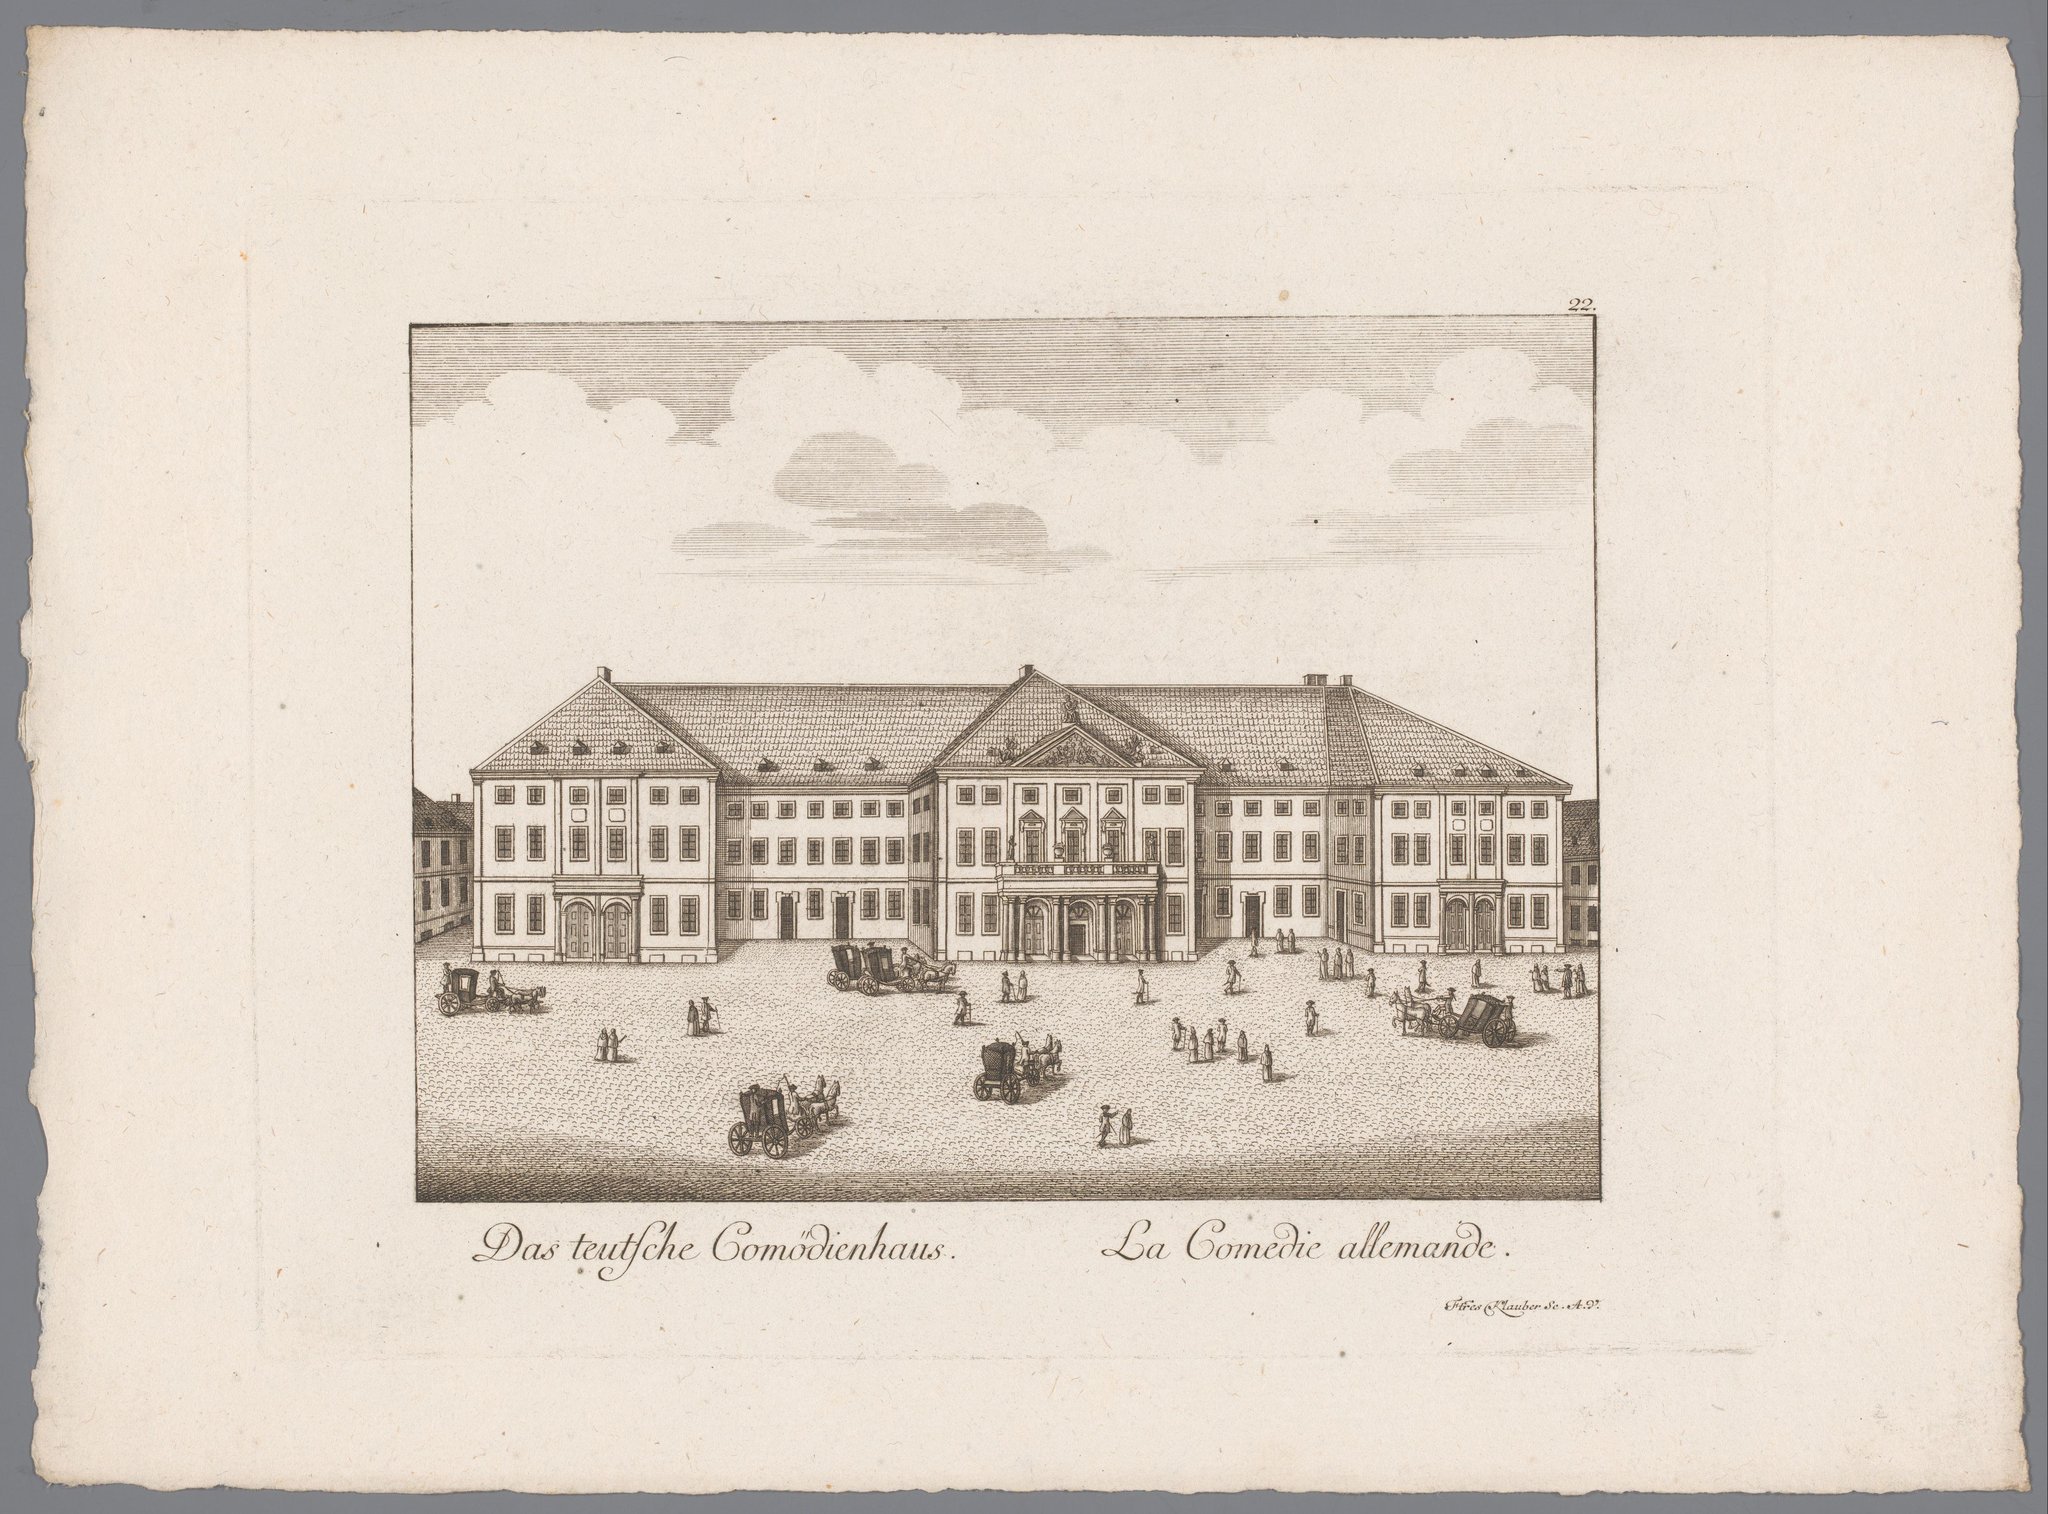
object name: print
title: Das Teutsche Comödienhaus / La comedie Allemande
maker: christian friedrich schwan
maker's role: bookseller, publisher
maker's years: 1733-1815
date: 1782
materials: paper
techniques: engraving, etching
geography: augsburg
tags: theatre (building)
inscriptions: collector's mark: Lugt 2228